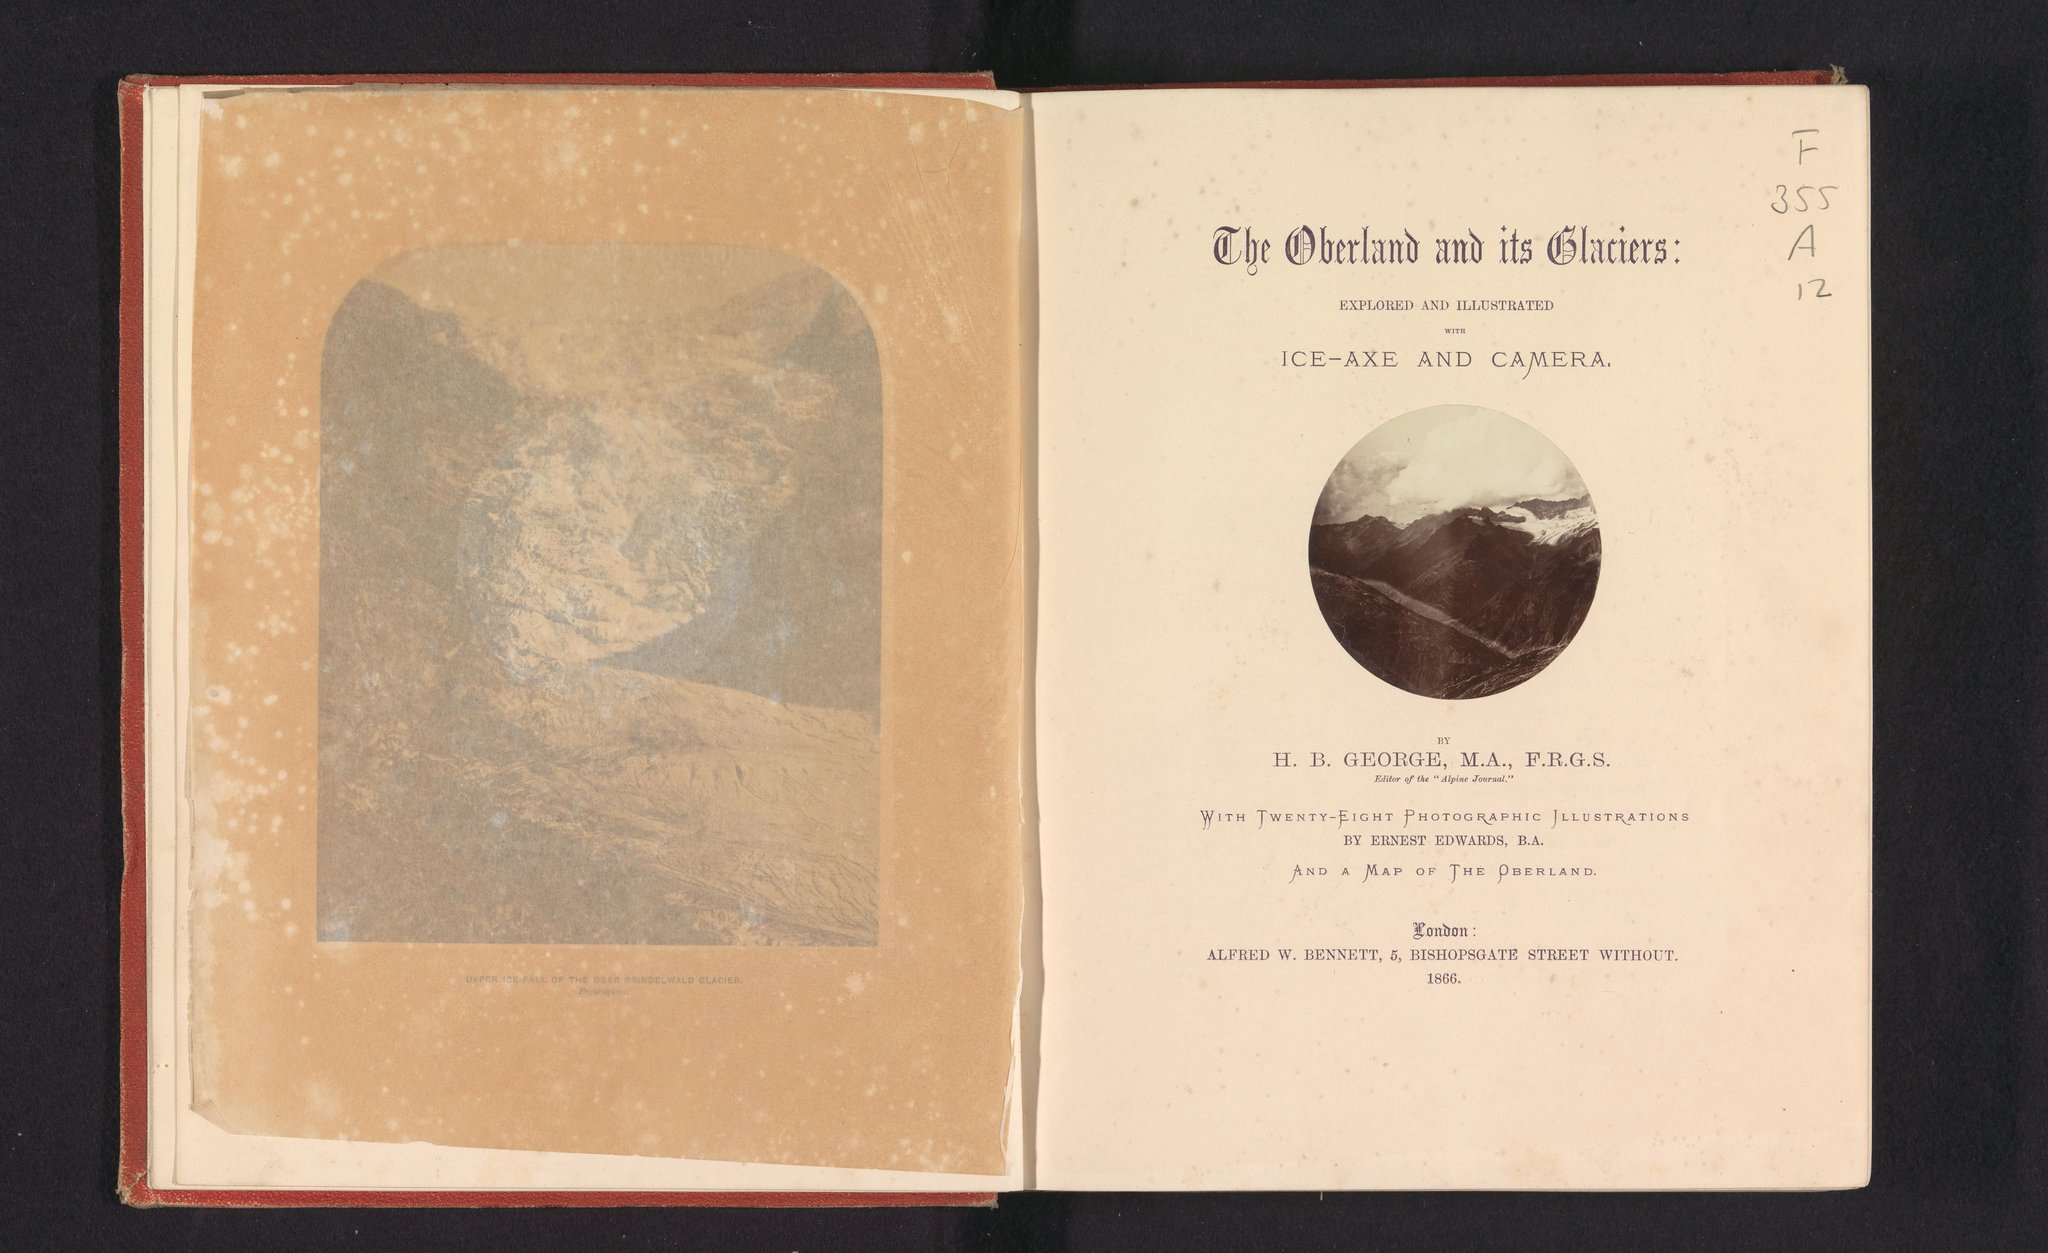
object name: book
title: The Oberland and its glaciers : explored and illustrated with ice-axe and camera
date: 1866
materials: cardboard, linen, paper, photographic support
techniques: albumen print, printing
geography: london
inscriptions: inscription: ‘June 1985’